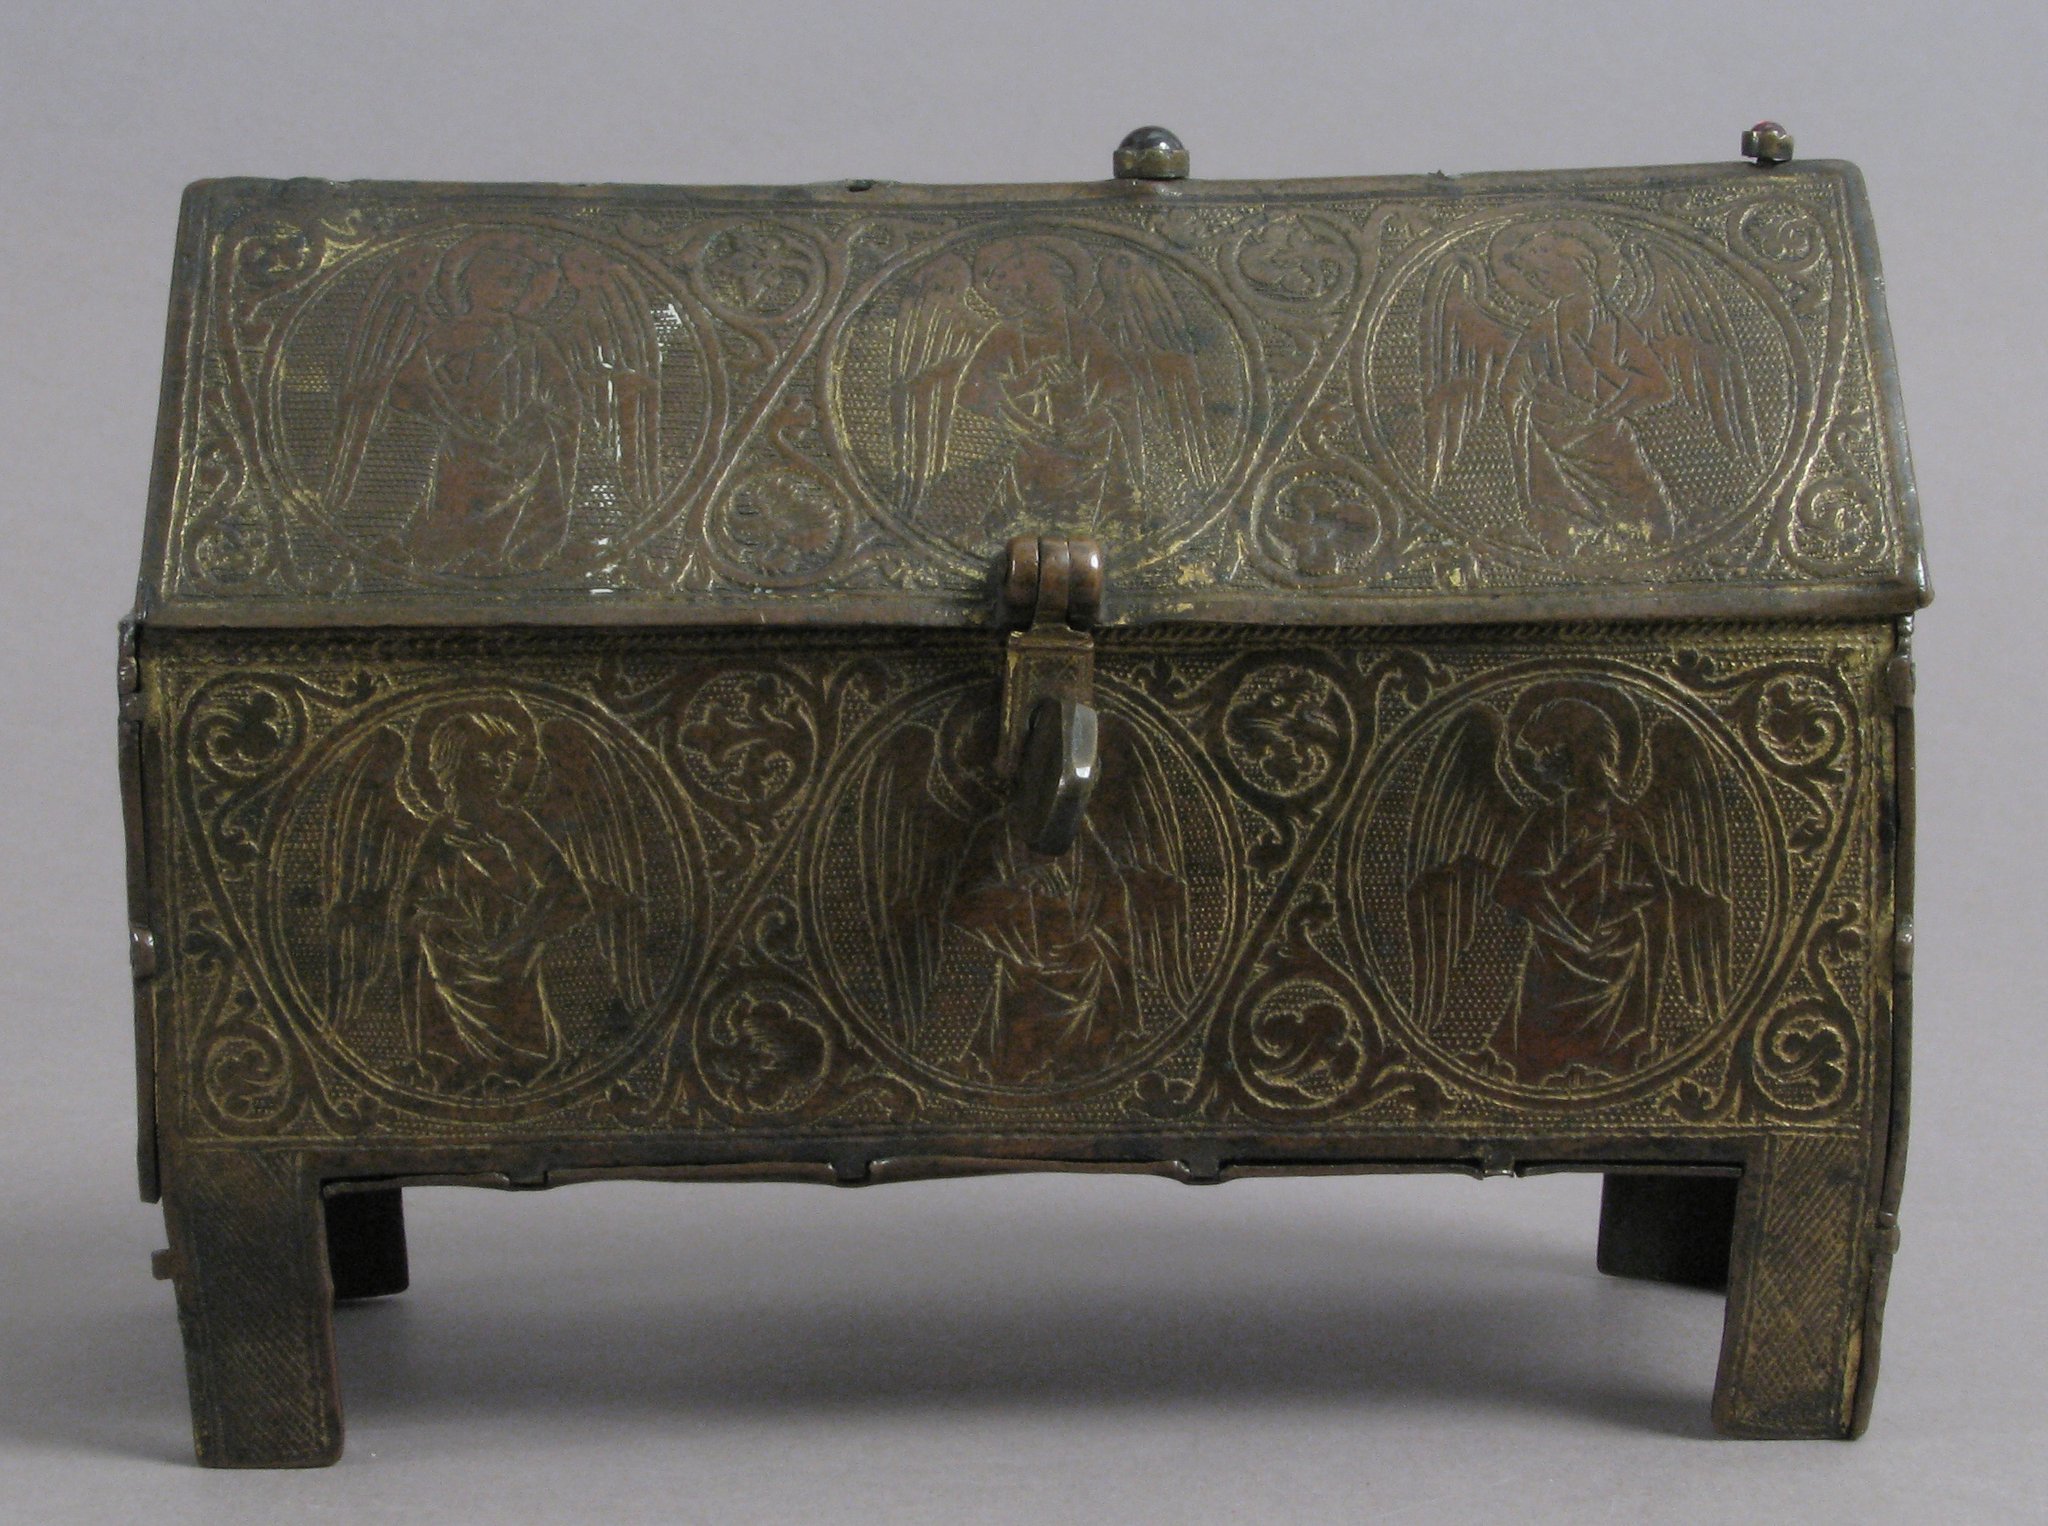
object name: chasse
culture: french or german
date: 1300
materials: gilt copper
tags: angels